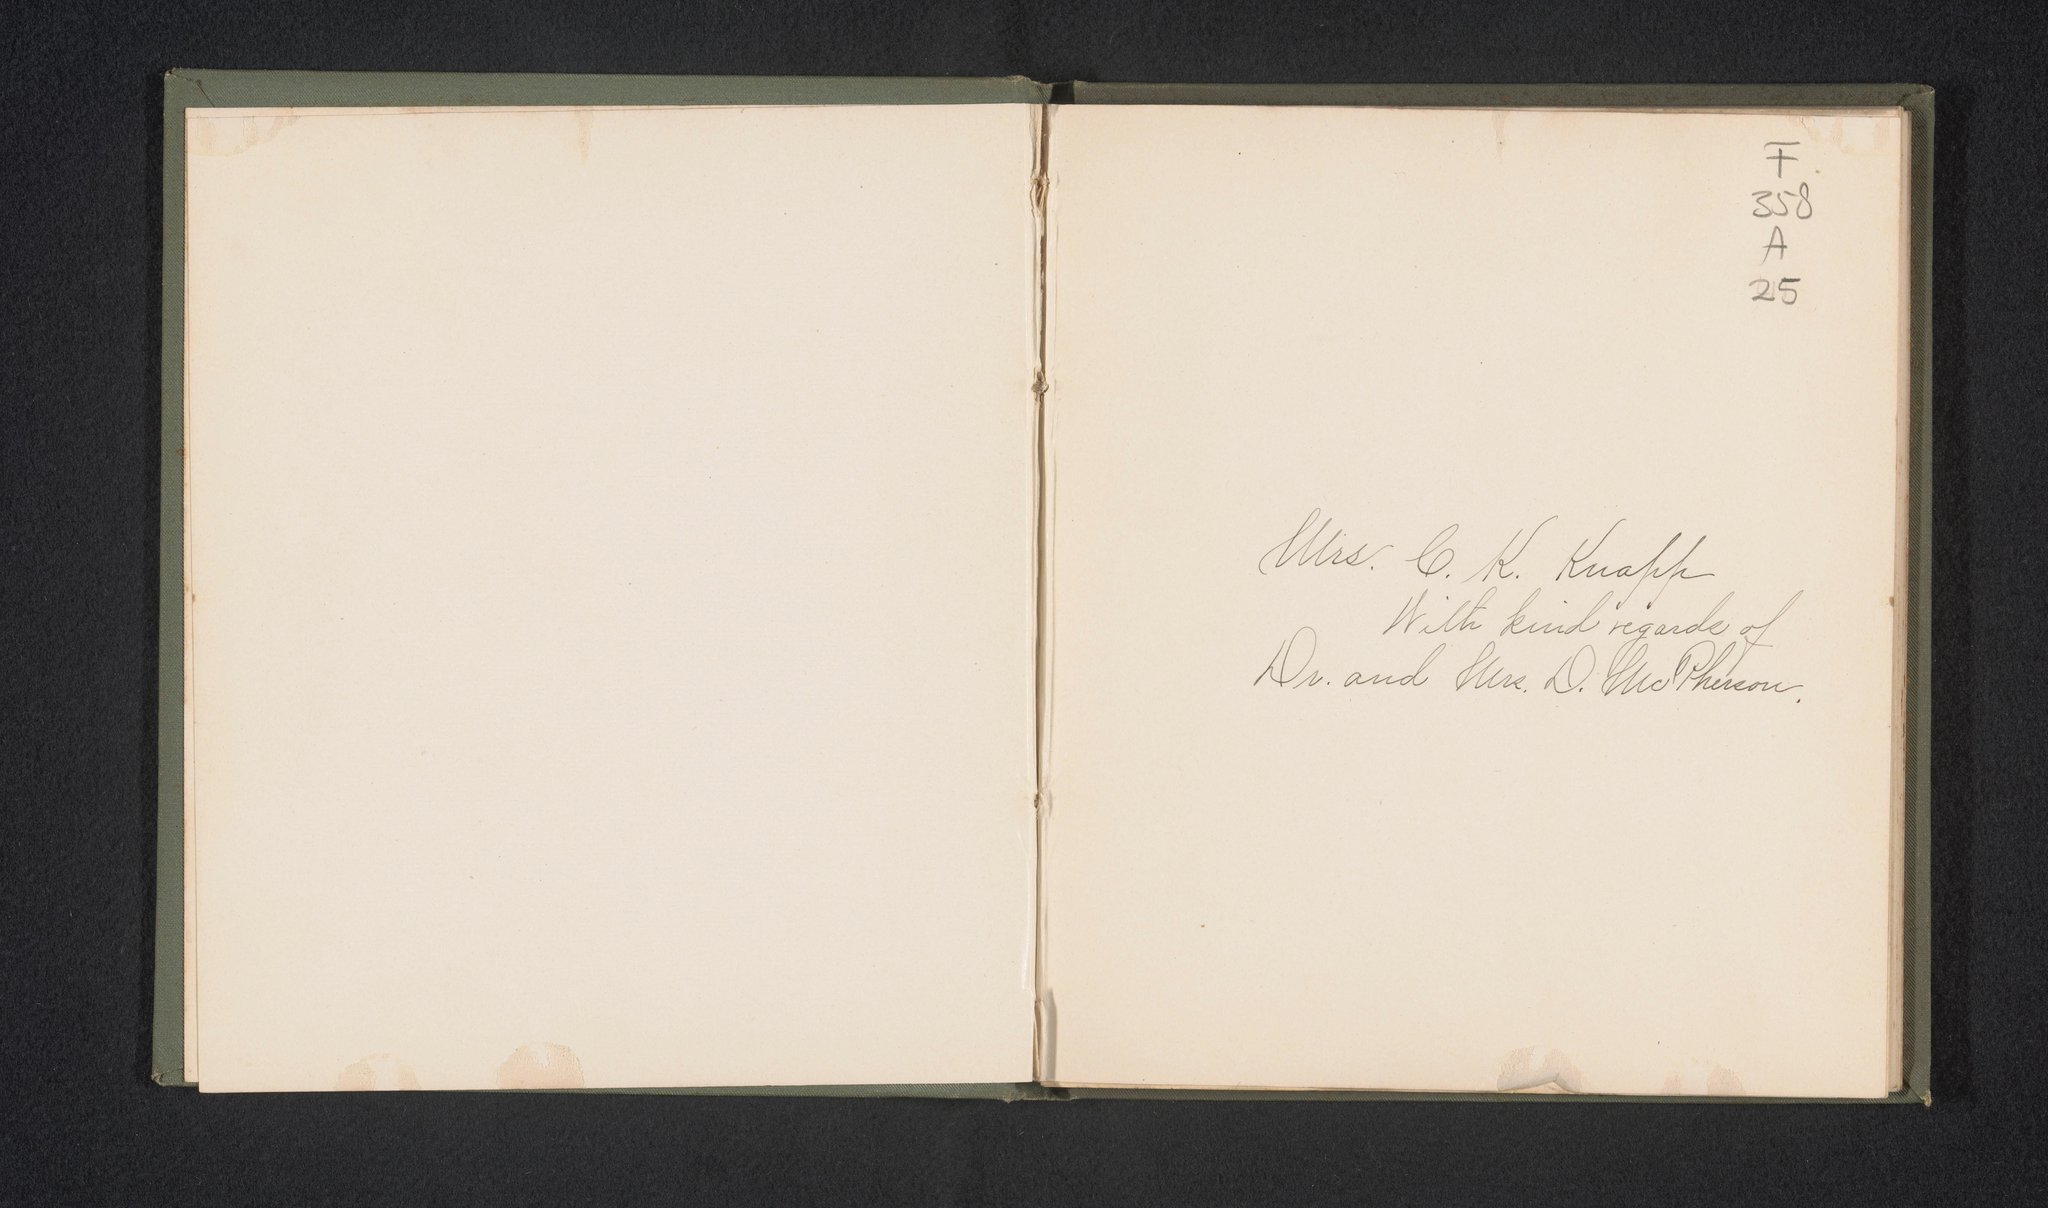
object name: book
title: Little lights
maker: harriet r. macpherson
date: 1888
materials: cardboard, paper, textile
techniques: albumen print, printing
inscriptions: annotation: ‘Mis C. K. Knapp/ with kind regards of/ Dr and M. D. McPherson’, annotation: ‘out of print Edition? 15:00/ Tipped in Frontis’, annotation: ‘OCT/ 1988’